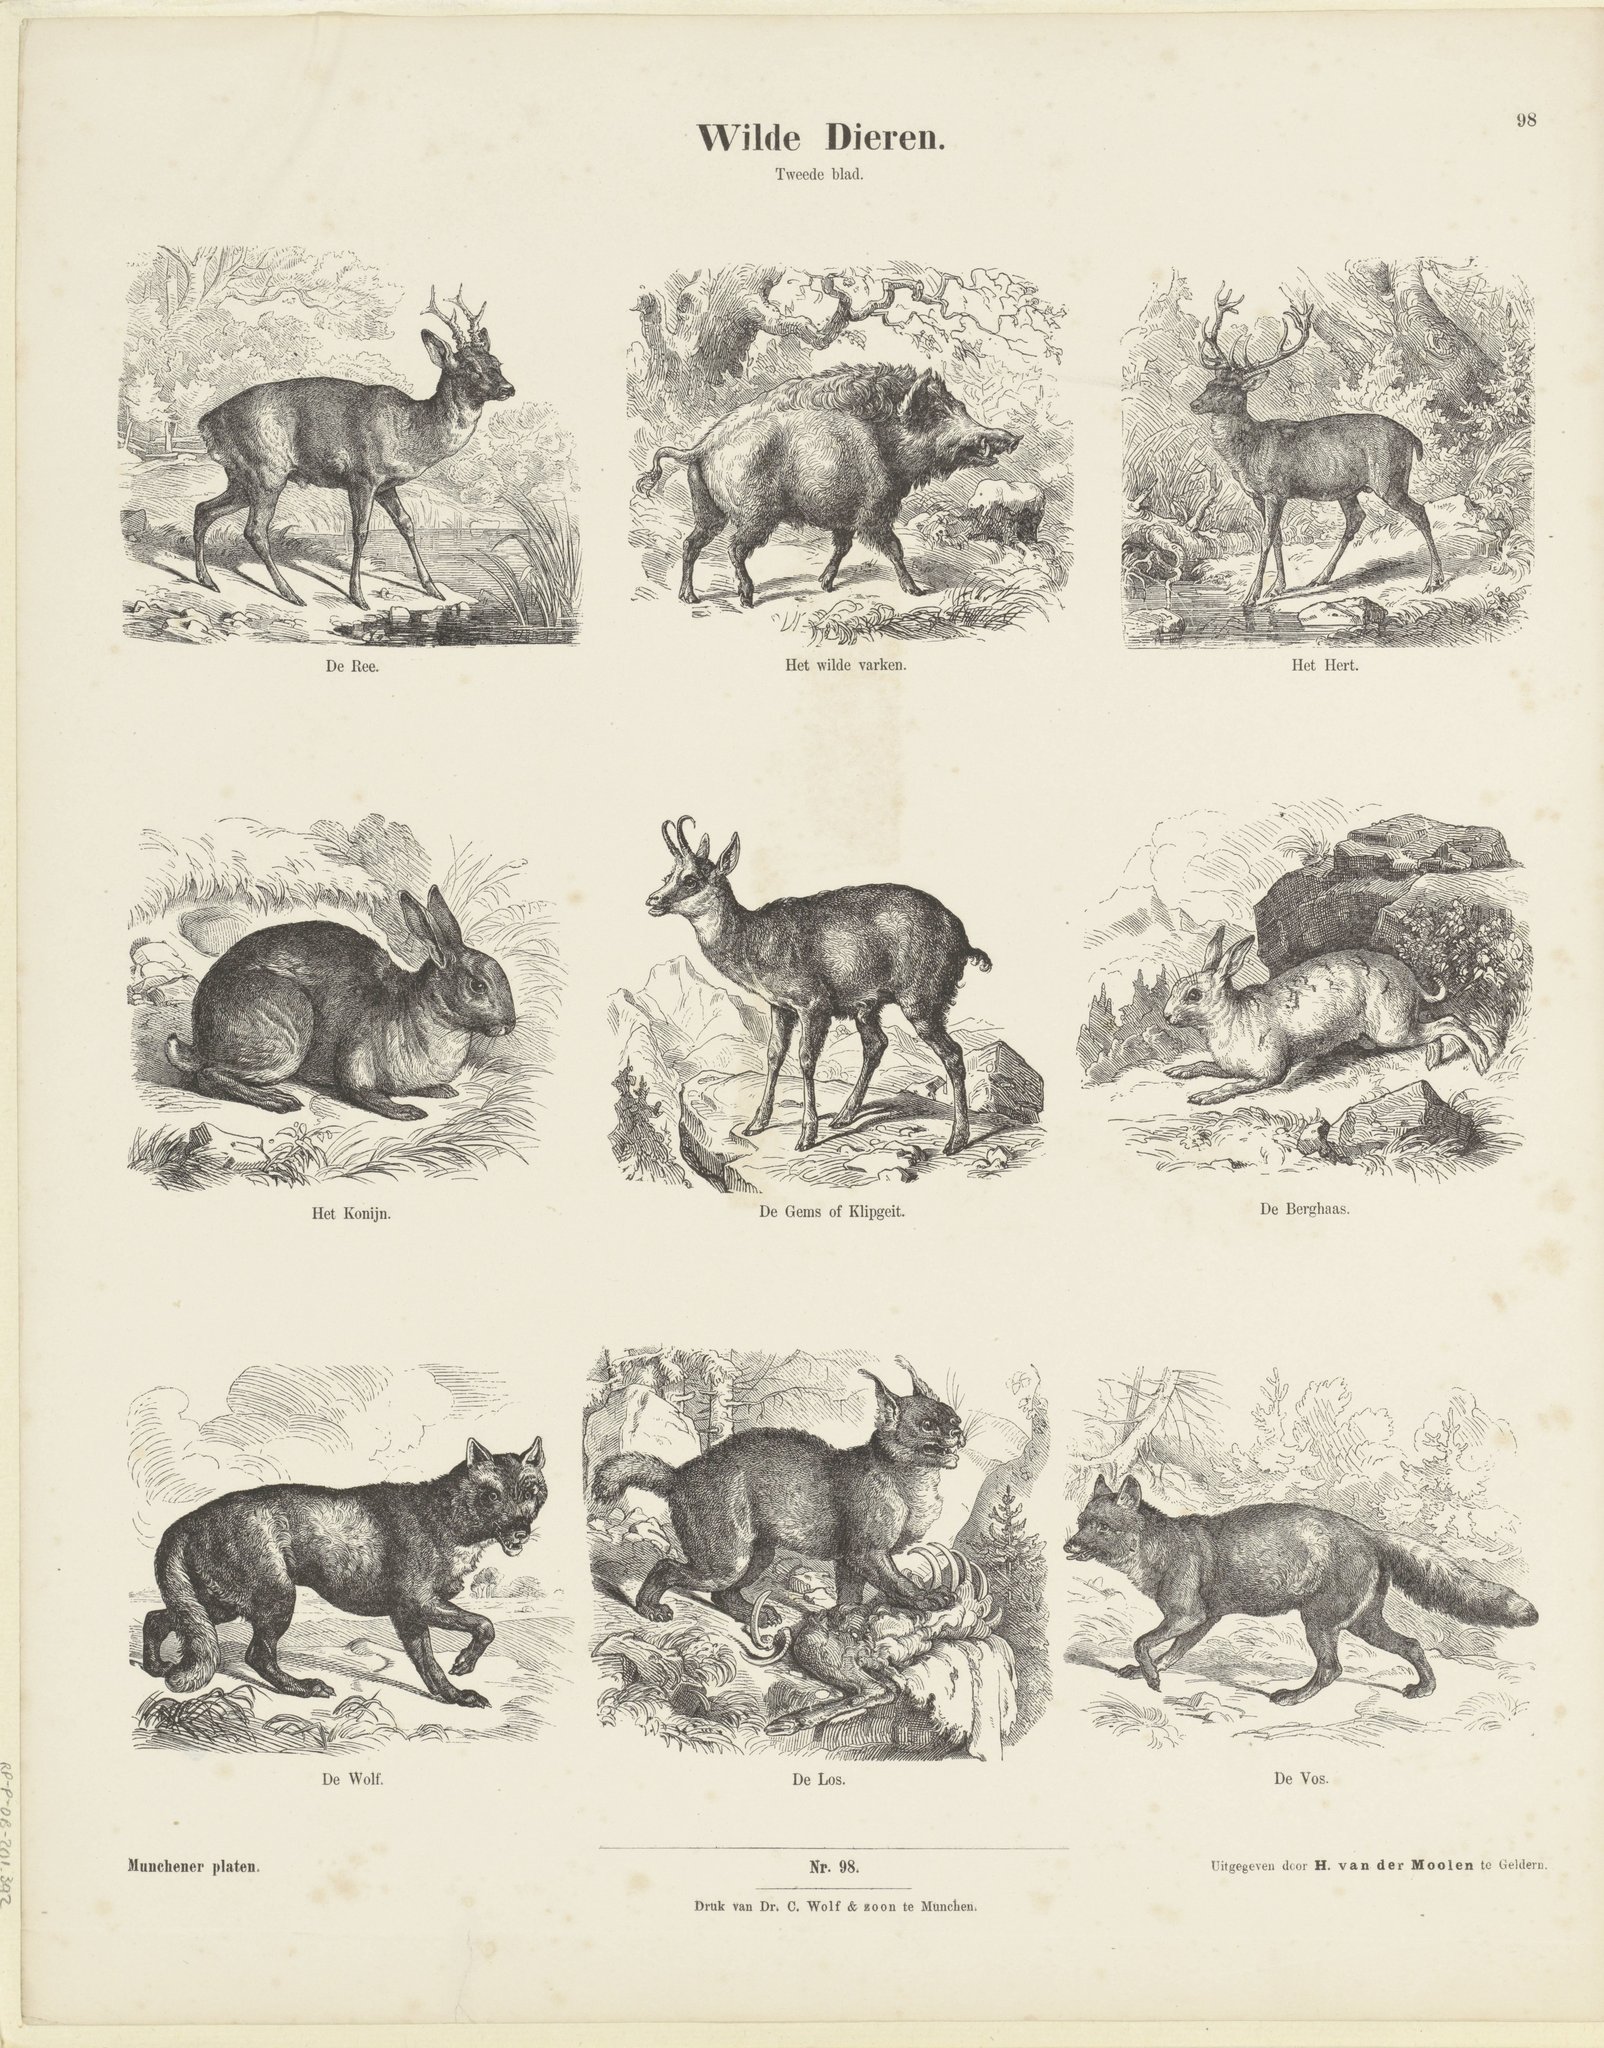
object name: popular print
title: Munchener platen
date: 1820-1843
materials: paper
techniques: letterpress printing, engraving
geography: munich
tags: hoofed animals: deer, animals, hoofed animals: deer - ff - fabulous animals (sometimes wrongly called 'grotesques'); 'mostri' (ripa), hoofed animals: boar, rodents: rabbit, beasts of prey, predatory animals: wolf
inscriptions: collector's mark: Lugt 2760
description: Blad met 9 voorstellingen van dieren, waaronder een ree, een everzwijn, een konijn en een wolf. Onder elke afbeelding een onderschrift. Genummerd midden onder: Nro. 98. Genummerd rechtsboven: 98.